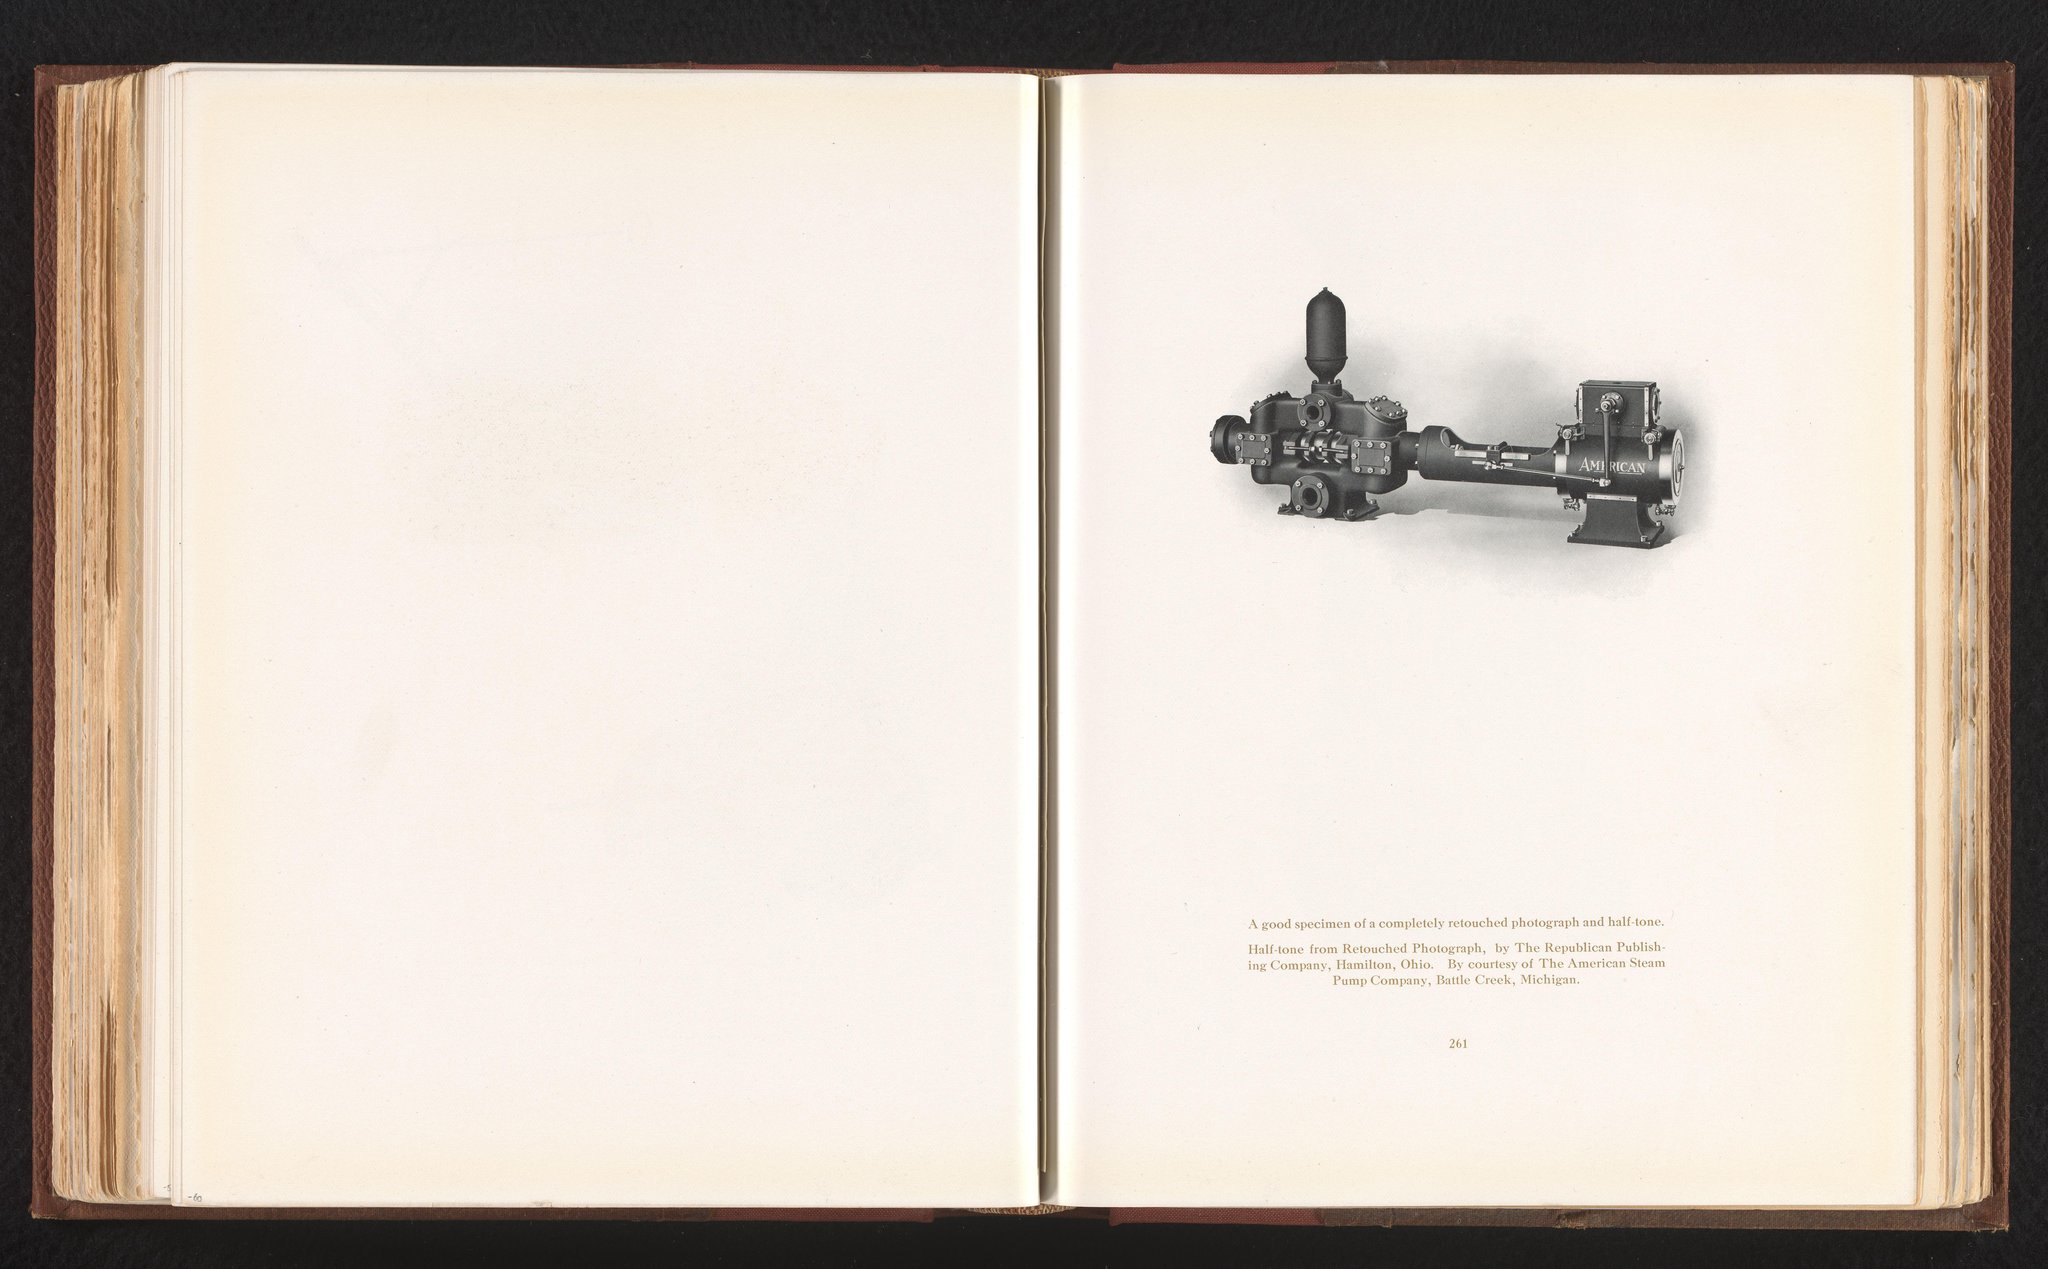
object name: page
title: Mechanisch onderdeel van de American Steam Pump Company te Battle Creek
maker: Anonymous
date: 1904-1909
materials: paper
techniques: autotype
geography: hamilton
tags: machines, engines ~ crafts and industries